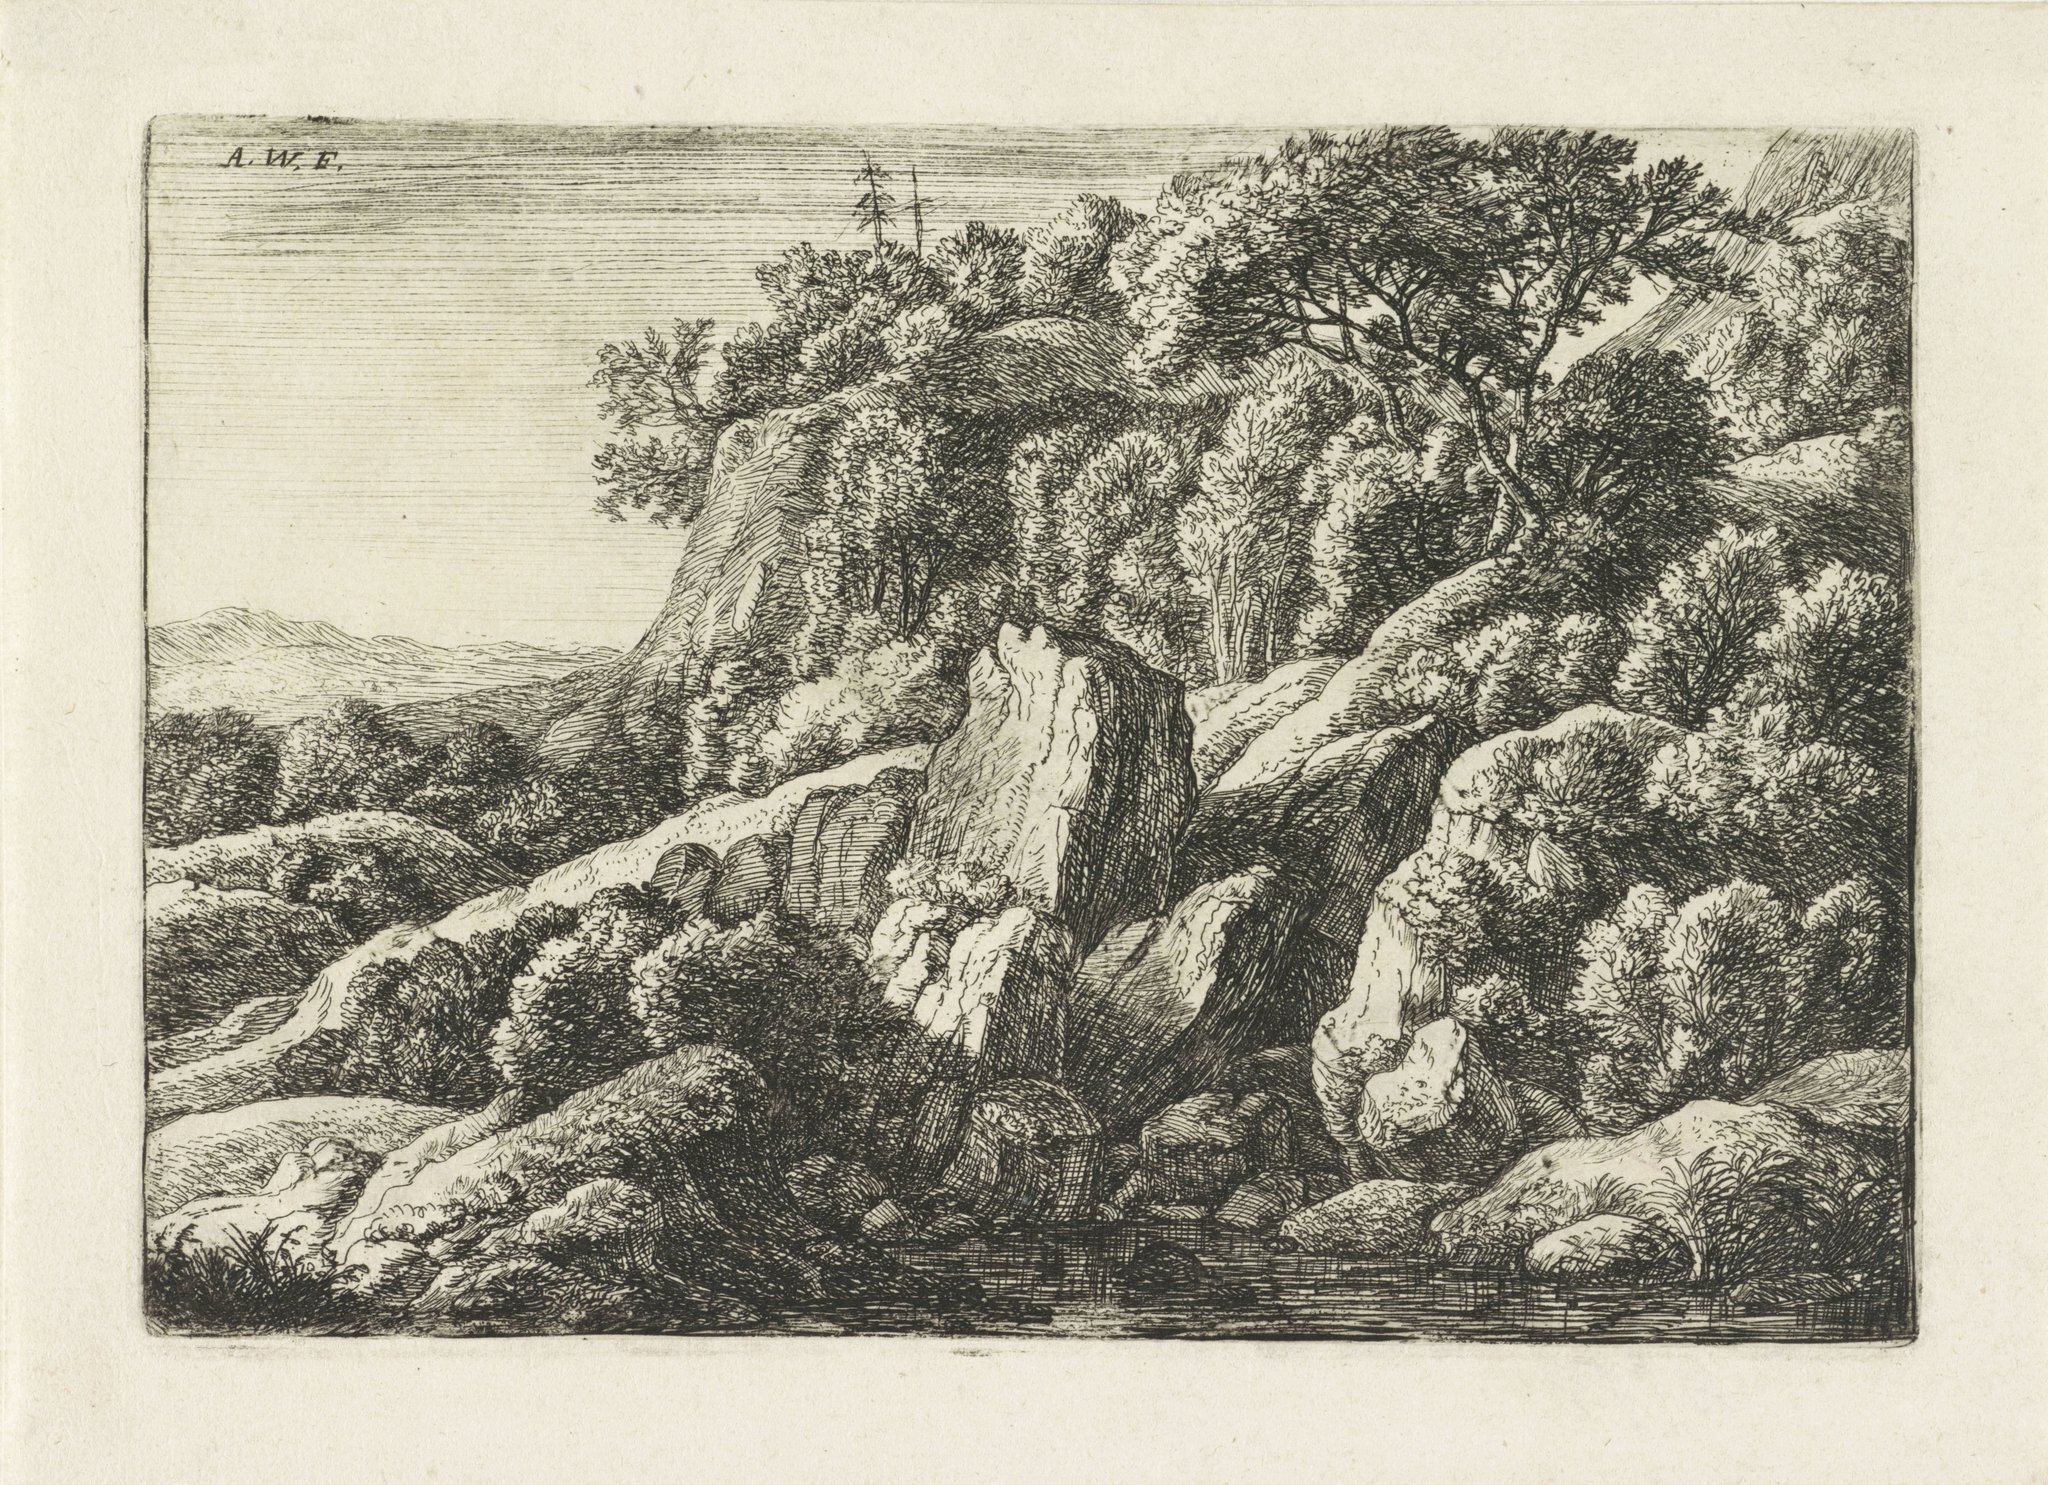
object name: print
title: Landschappen met rotspartijen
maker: anthonie waterloo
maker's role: draughtsman, painter, print maker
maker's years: 1609-1690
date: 1630-1663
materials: paper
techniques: etching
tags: pond, pool, rock-formations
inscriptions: collector's mark: Lugt 240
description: Er is een heuvelachtig landschap met rotsen en bomen te zien. Rechtsvoor is een kleine waterpartij weergegeven.